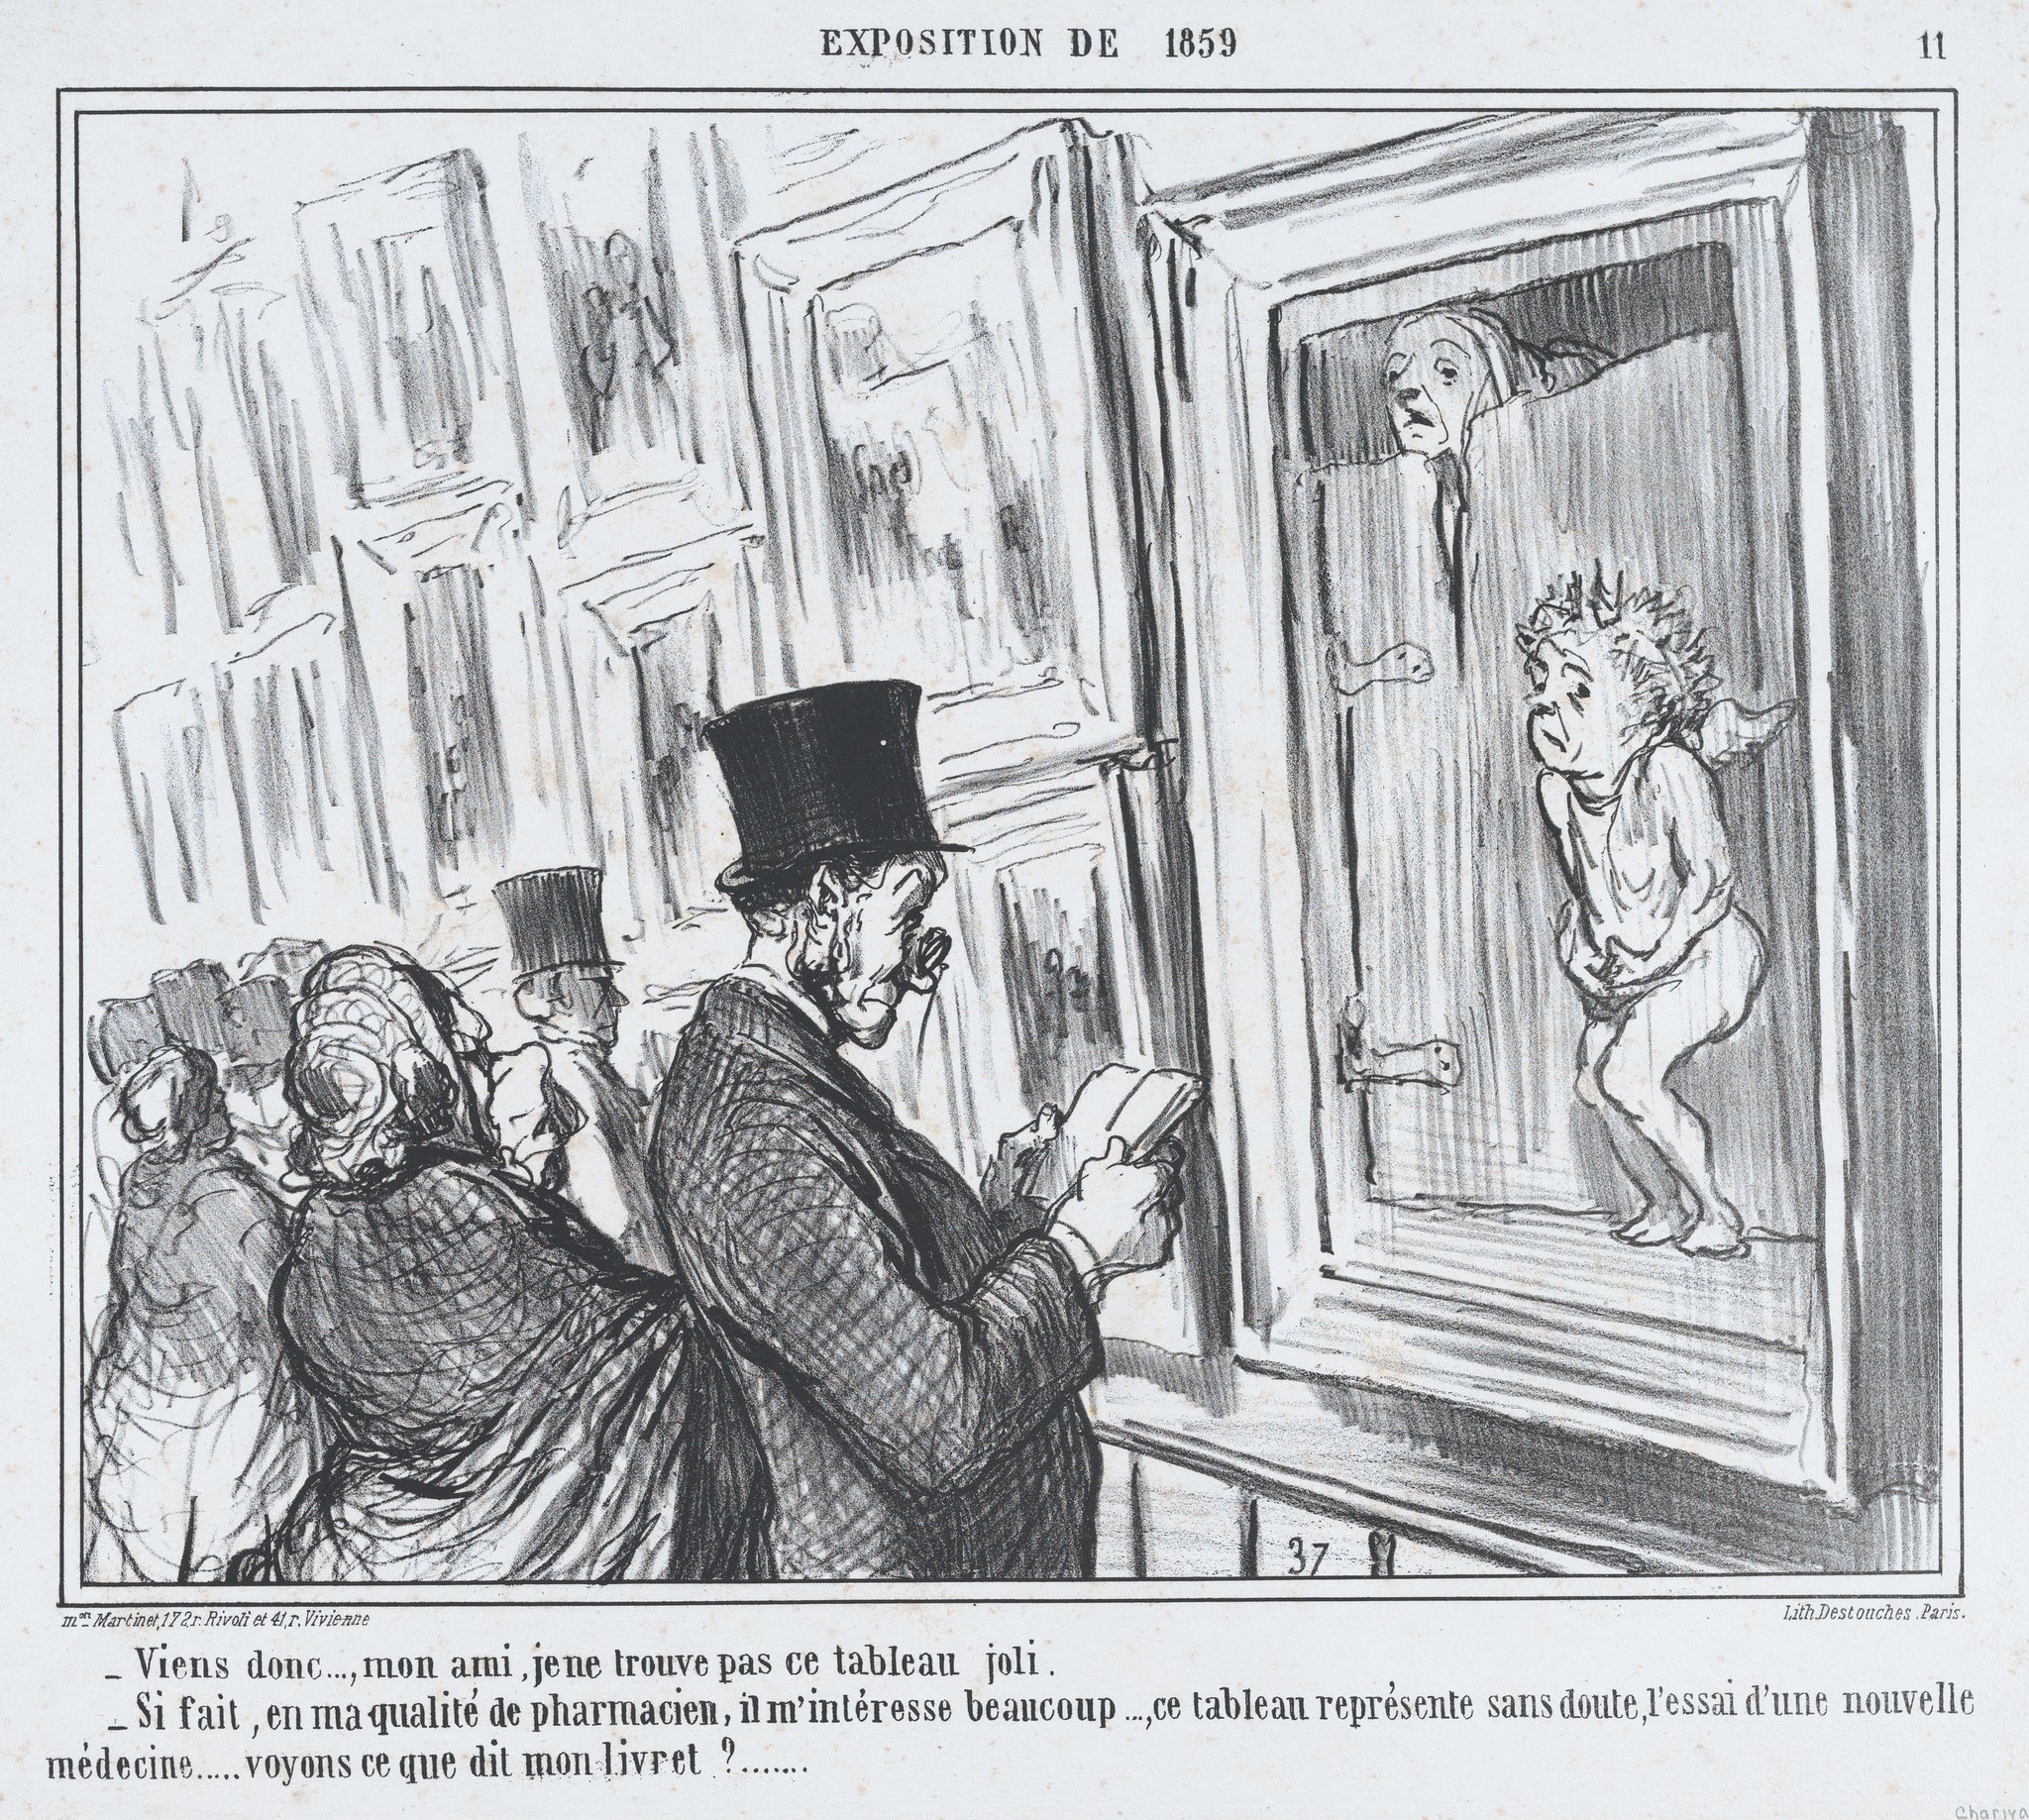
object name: print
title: Viens donc..., mon ami, je ne trouve pas ce tableau joli, from L'Exposition de 1859, published in Le Charivari, June 21, 1859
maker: honoré daumier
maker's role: artist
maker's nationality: french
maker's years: 1808-1879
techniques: lithograph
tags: men,women